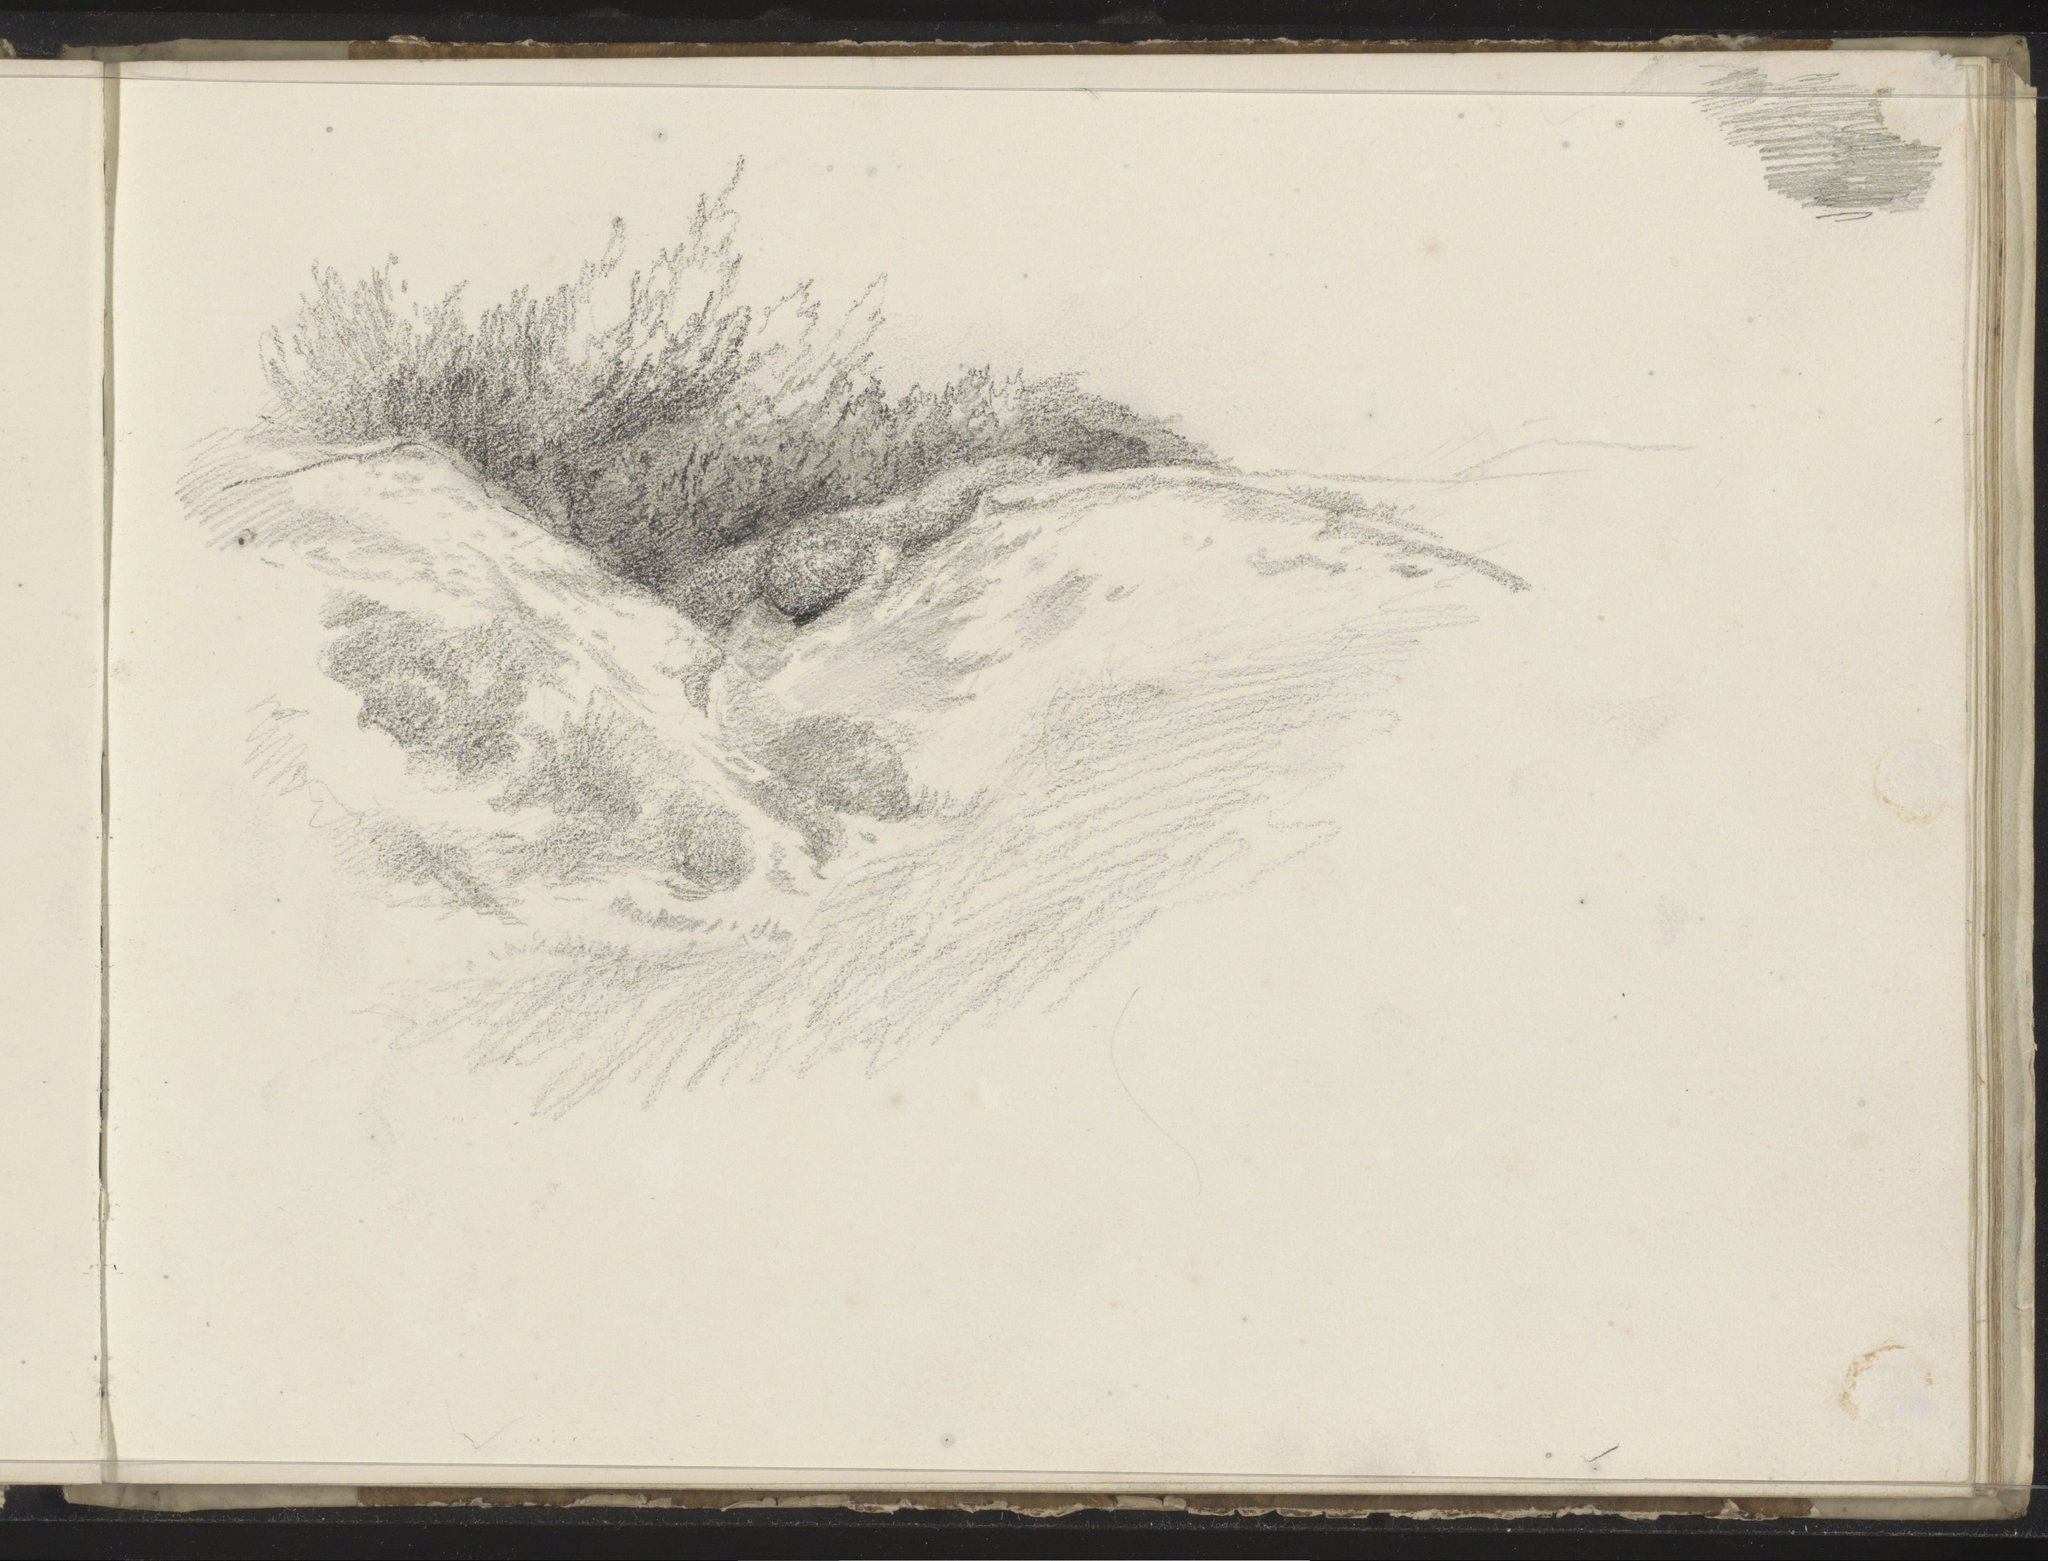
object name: sketchbook leaf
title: Met planten begroeide heuvels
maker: maria vos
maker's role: draughtsman, painter, print maker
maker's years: 1824-1906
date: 1834-1906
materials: paper, pencil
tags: low hill country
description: Blad 20 recto uit een schetsboek met 39 bladen.